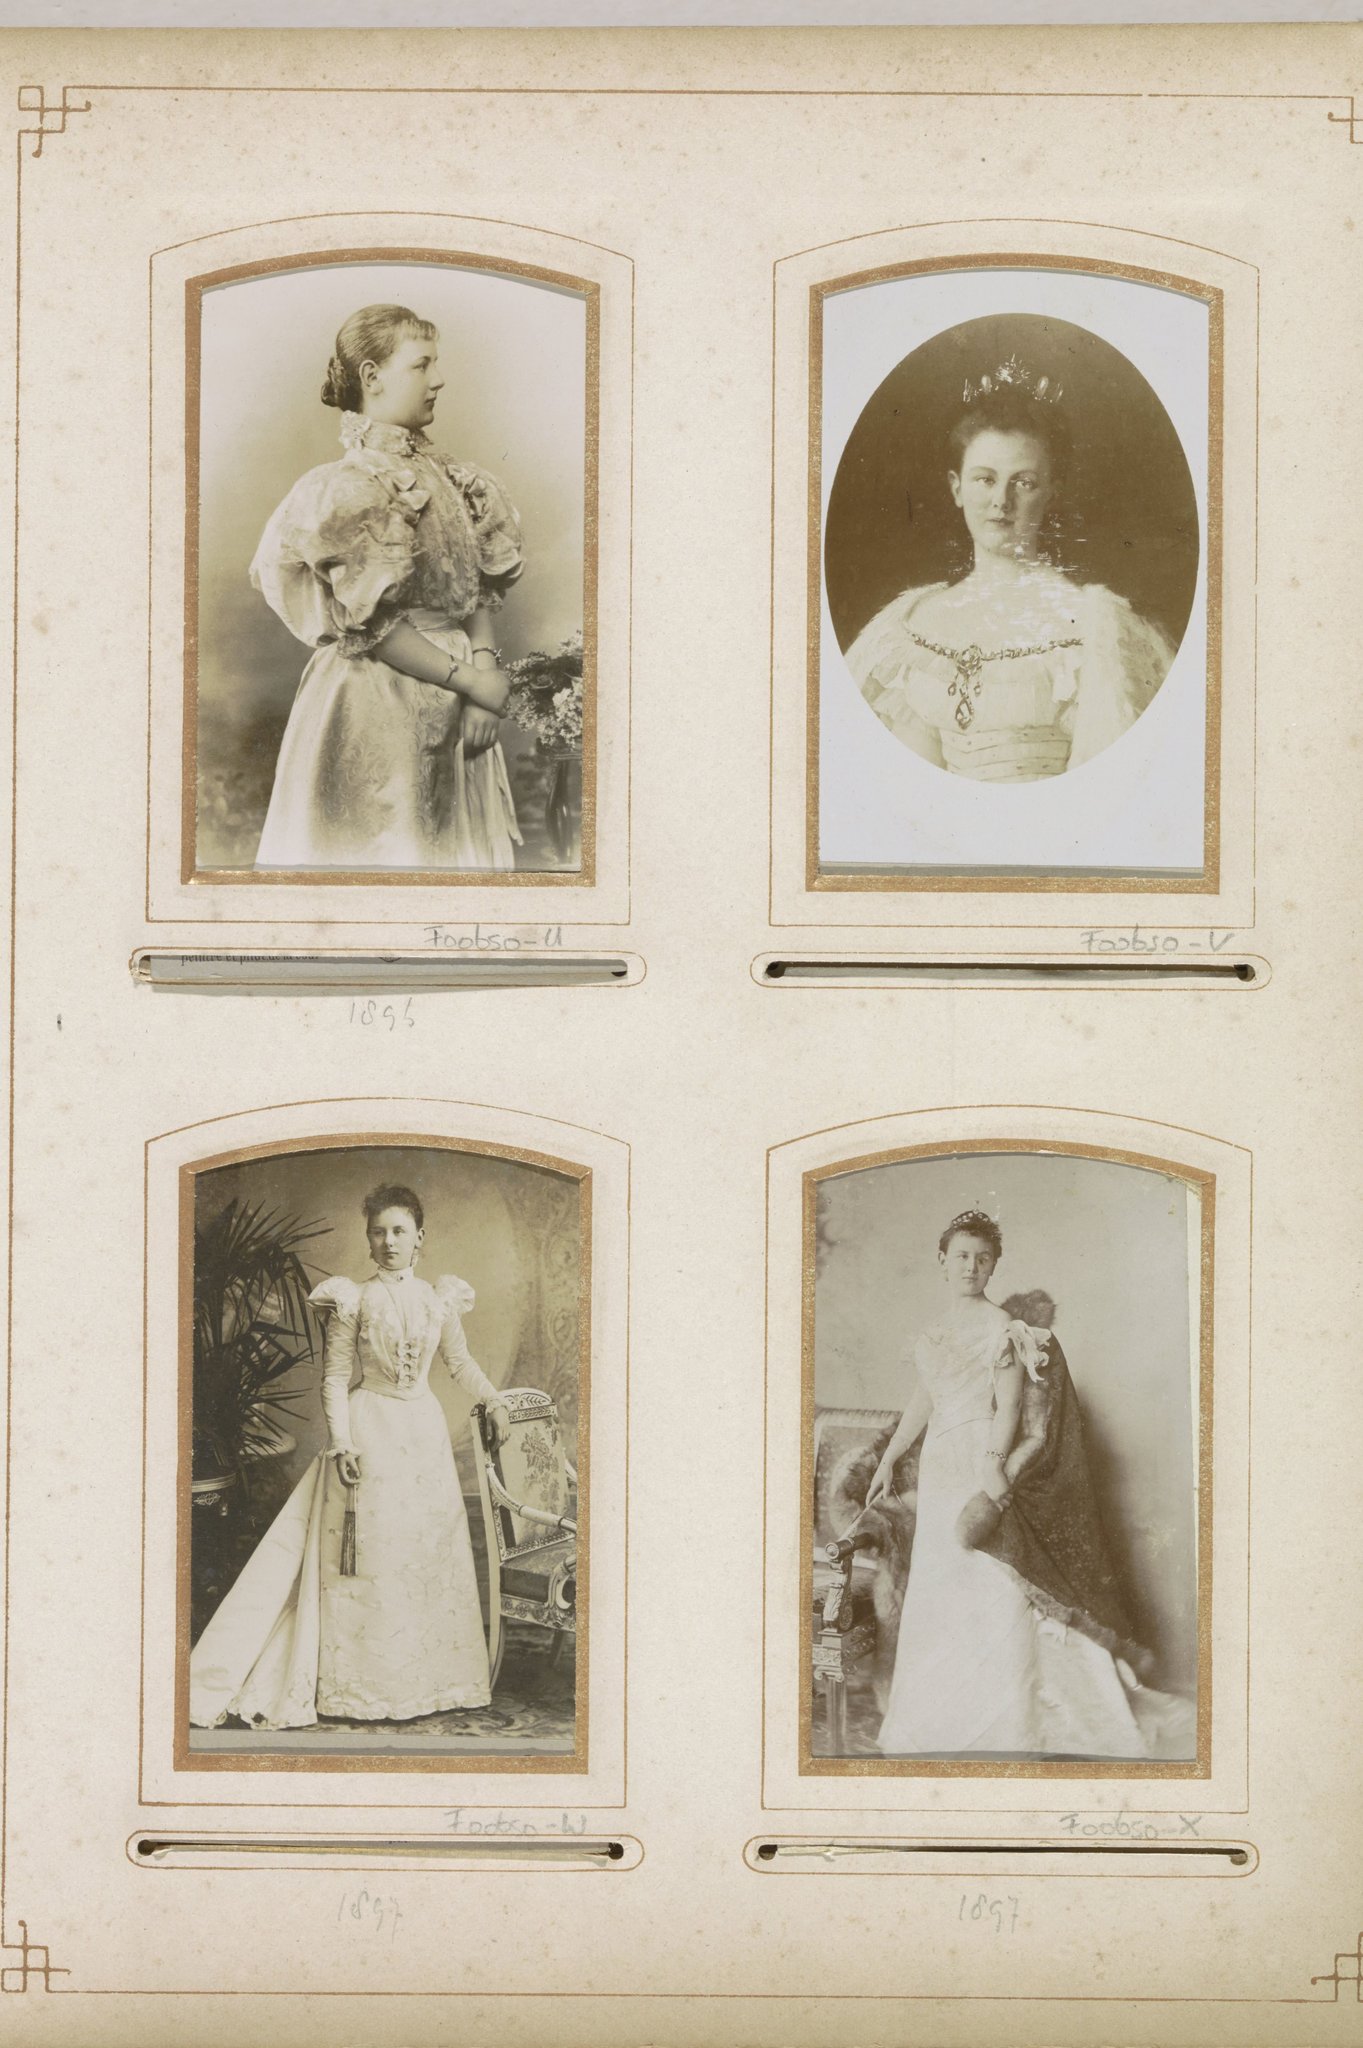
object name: carte de visite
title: Portret van prinses Wilhelmina, staand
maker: kameke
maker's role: painter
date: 1896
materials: paper, cardboard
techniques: gelatin silver print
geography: the hague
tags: print maker, wilhelmina of the netherlands, historical persons - bb - woman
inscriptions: inscription: ‘Kameke/ peintre et photo de la cour/ Reproductie/ La Haye/ Javastraat 20’